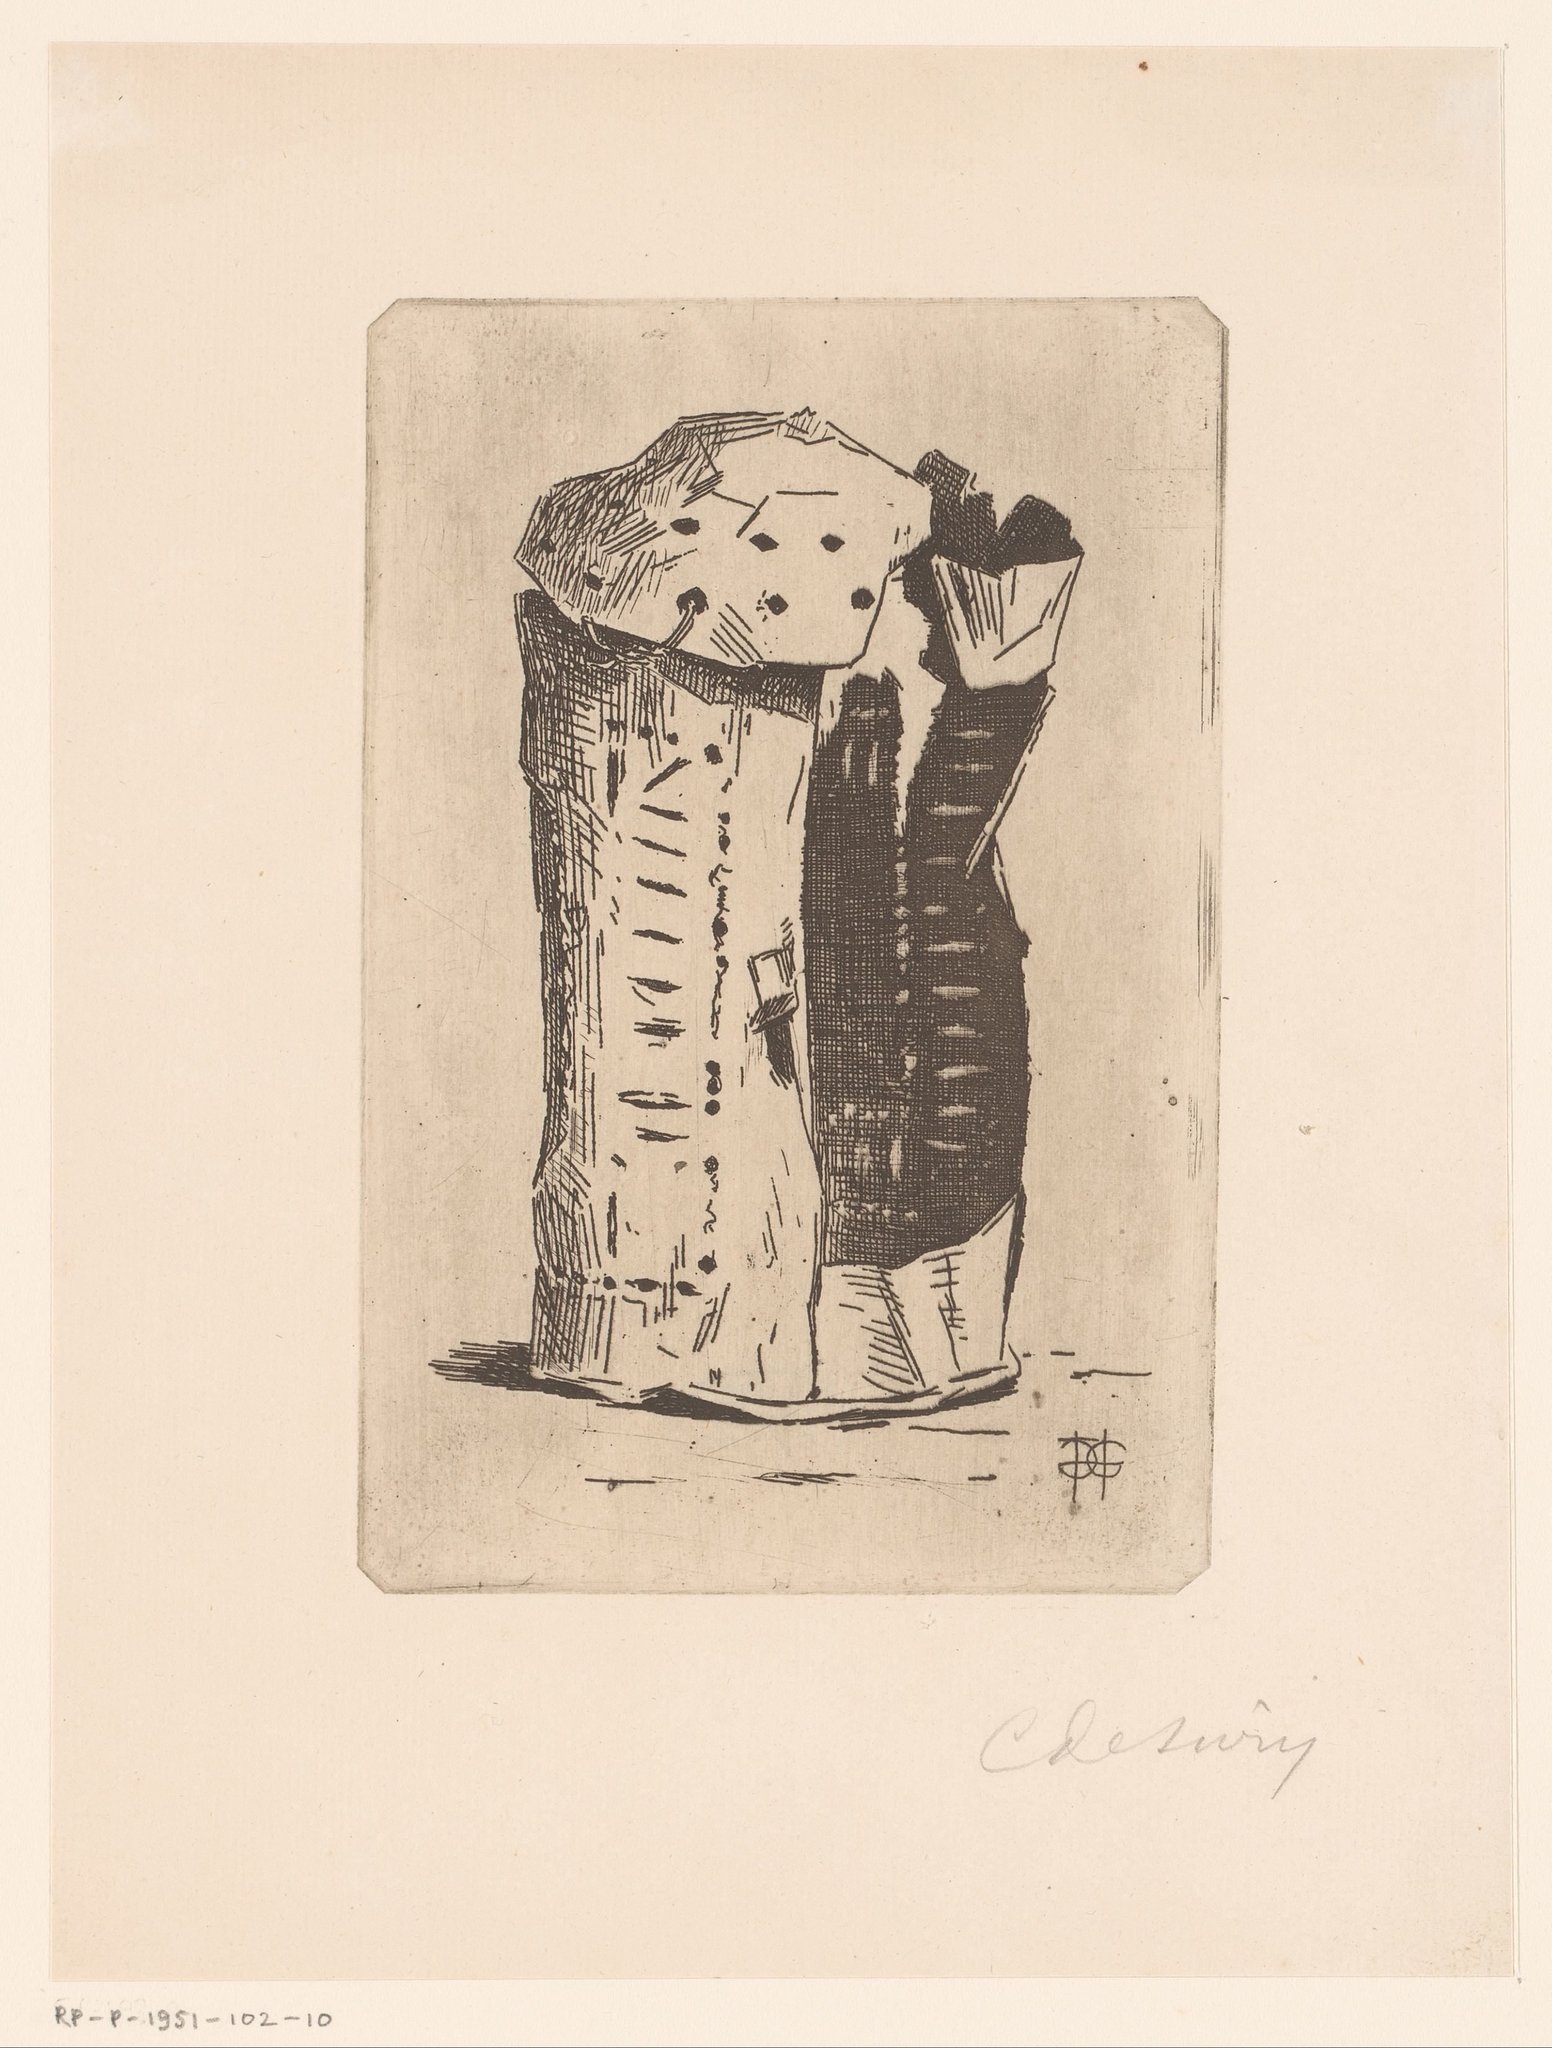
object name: print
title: Les Lanternes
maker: henri charles guérard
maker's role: print maker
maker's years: 1846-1897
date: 1876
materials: paper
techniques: etching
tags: lantern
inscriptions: collector's mark: Lugt 2228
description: Maakt waarschijnlijk deel uit van een tiendelige serie met lantaarns.